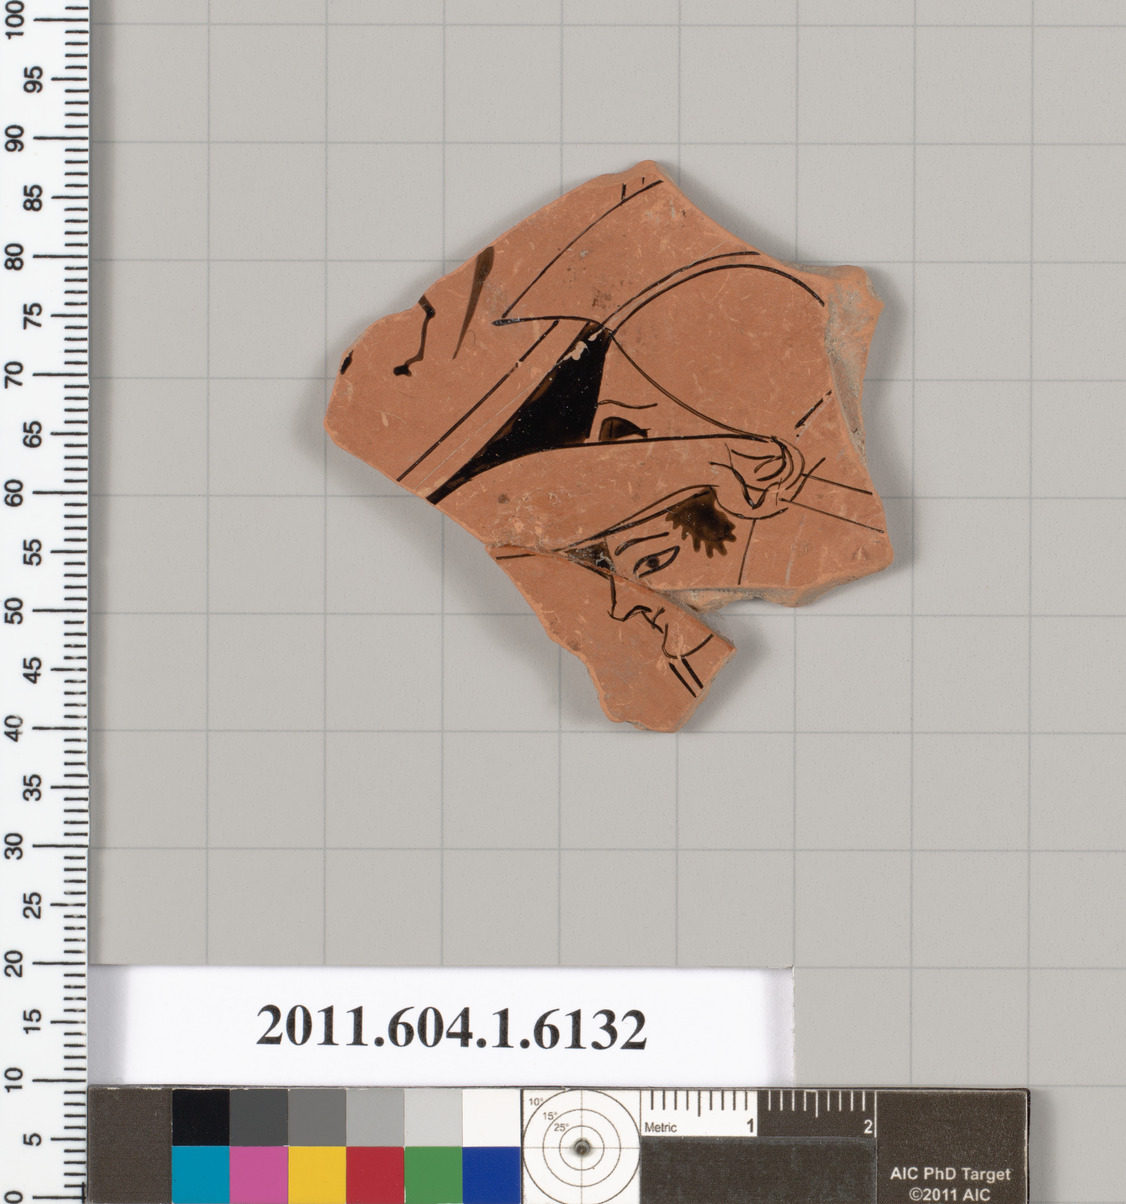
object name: kylix fragment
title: Terracotta fragment of a kylix (drinking cup)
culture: greek, attic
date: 520-500 BCE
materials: terracotta